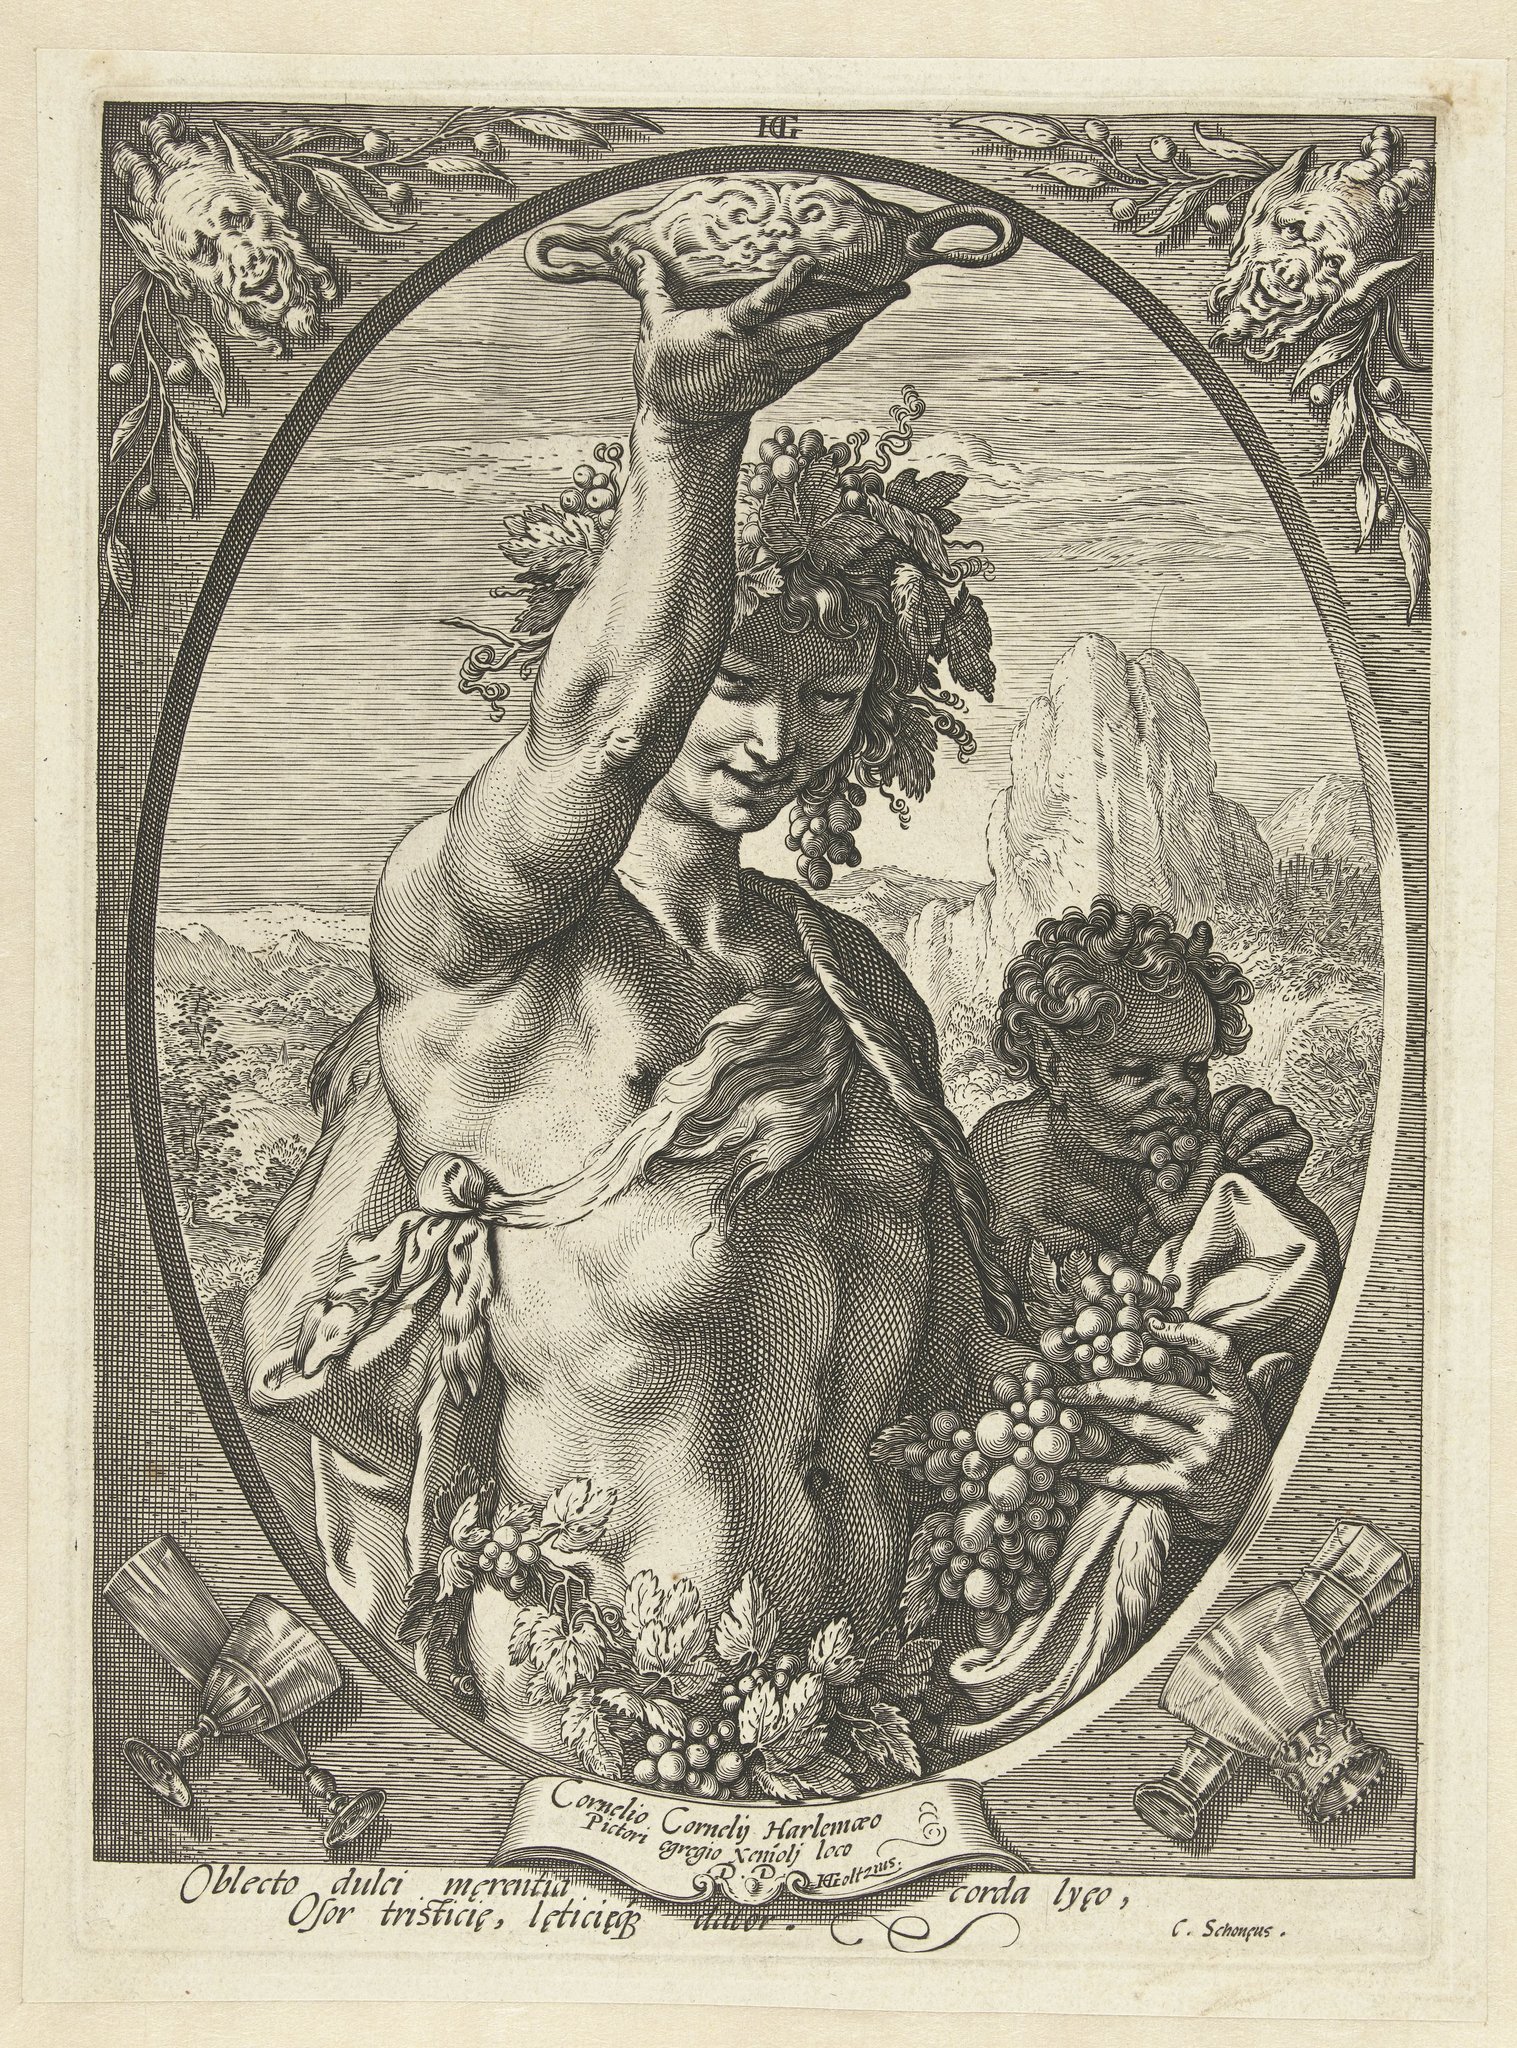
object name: print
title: Bacchus with a Drinking Bowl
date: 1593-1597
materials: paper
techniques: engraving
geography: haarlem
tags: (story of) bacchus (dionysus), liber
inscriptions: collector's mark: Lugt 2228, collector's mark: Lugt 2760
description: Cartouches with auricular motifs were used quite often in engravings, but here Bacchus holds a drinking bowl, a three-dimensional object entirely made up of kwab forms. That was original and daring: in reality such objects were almost certainly not yet made by 1596.